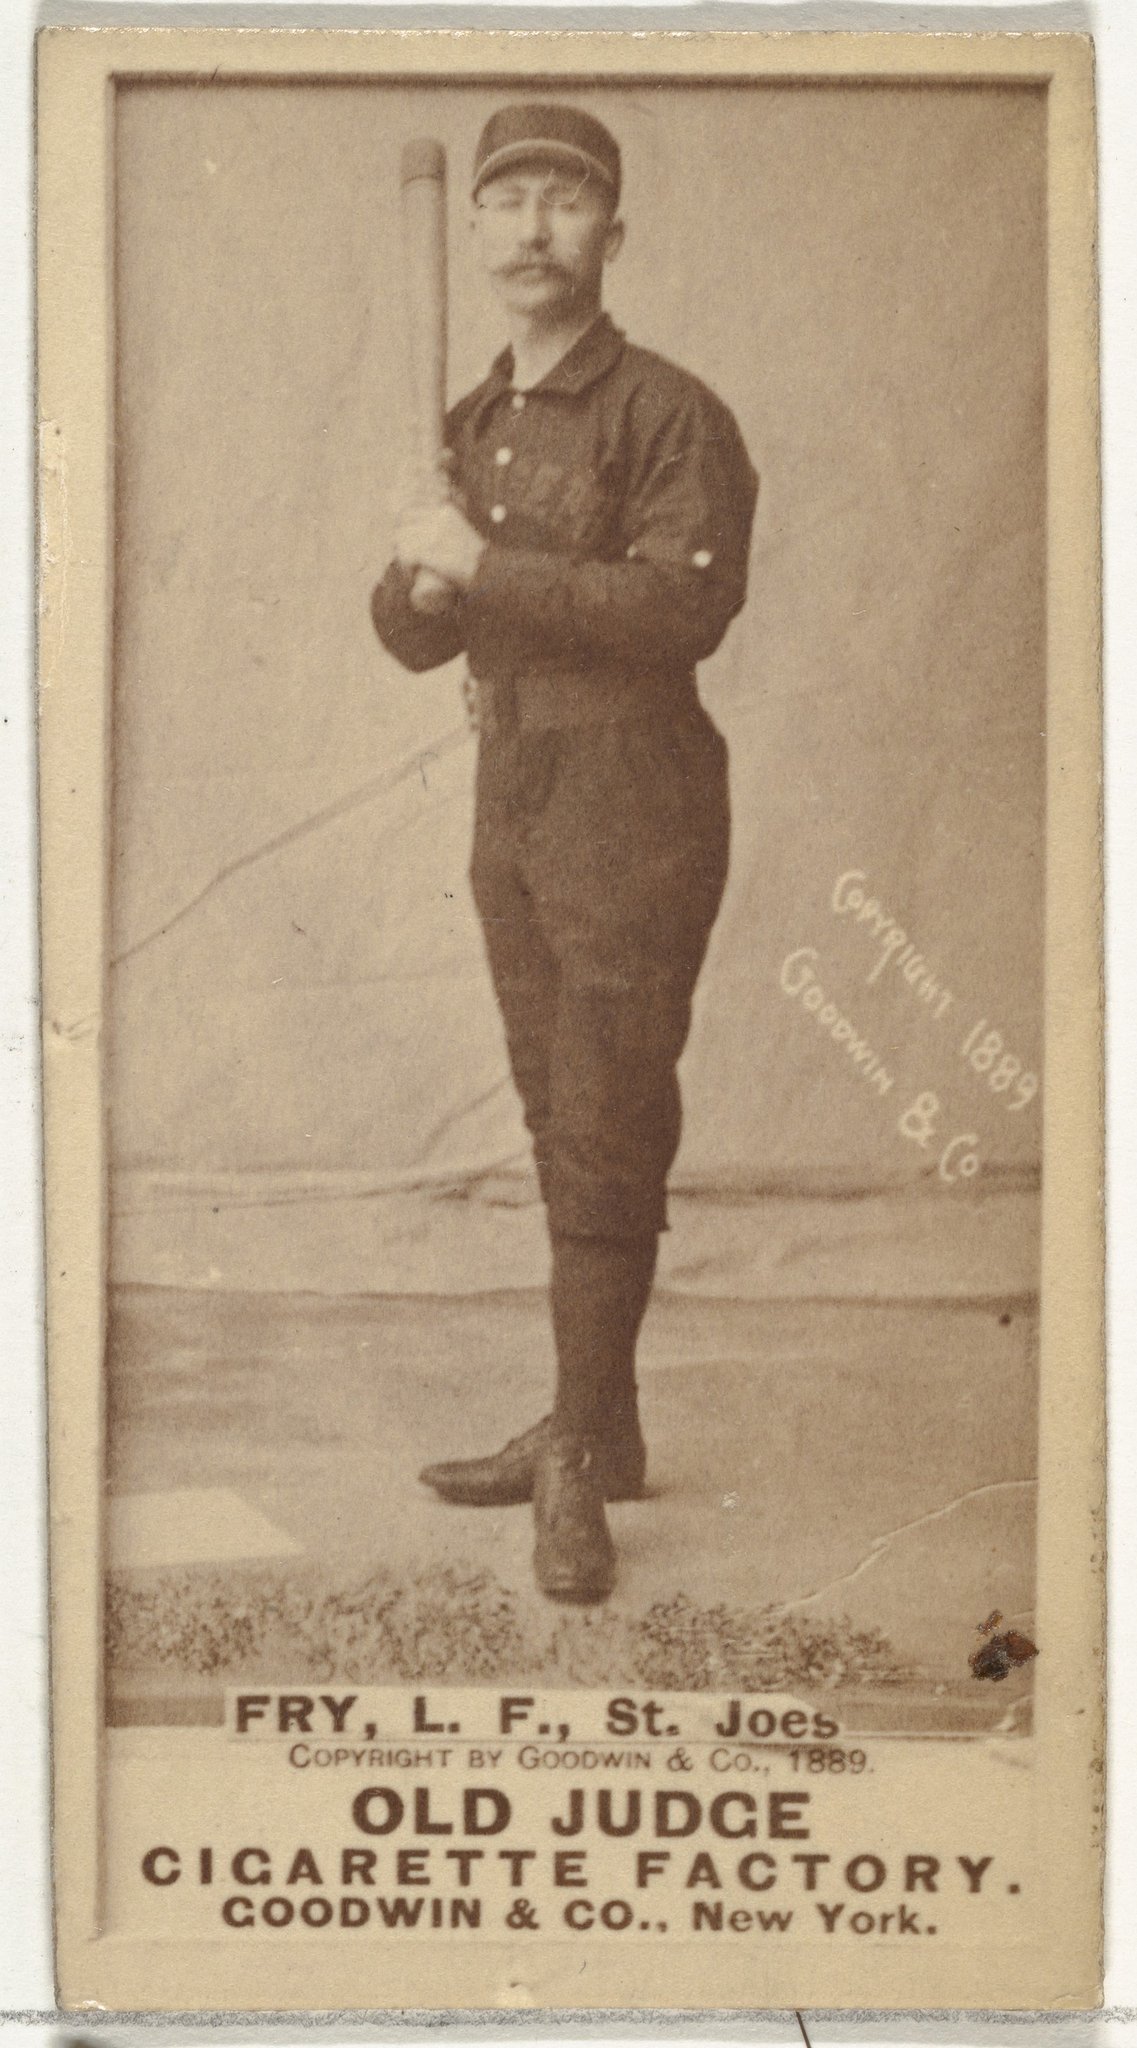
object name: baseball card, photograph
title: William J. Frey, Left Field, St. Joseph Clay Eaters, from the Old Judge series (N172) for Old Judge Cigarettes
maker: goodwin & company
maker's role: publisher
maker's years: 1850-1950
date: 1889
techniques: albumen silver print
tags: men,portraits,baseball,athletes